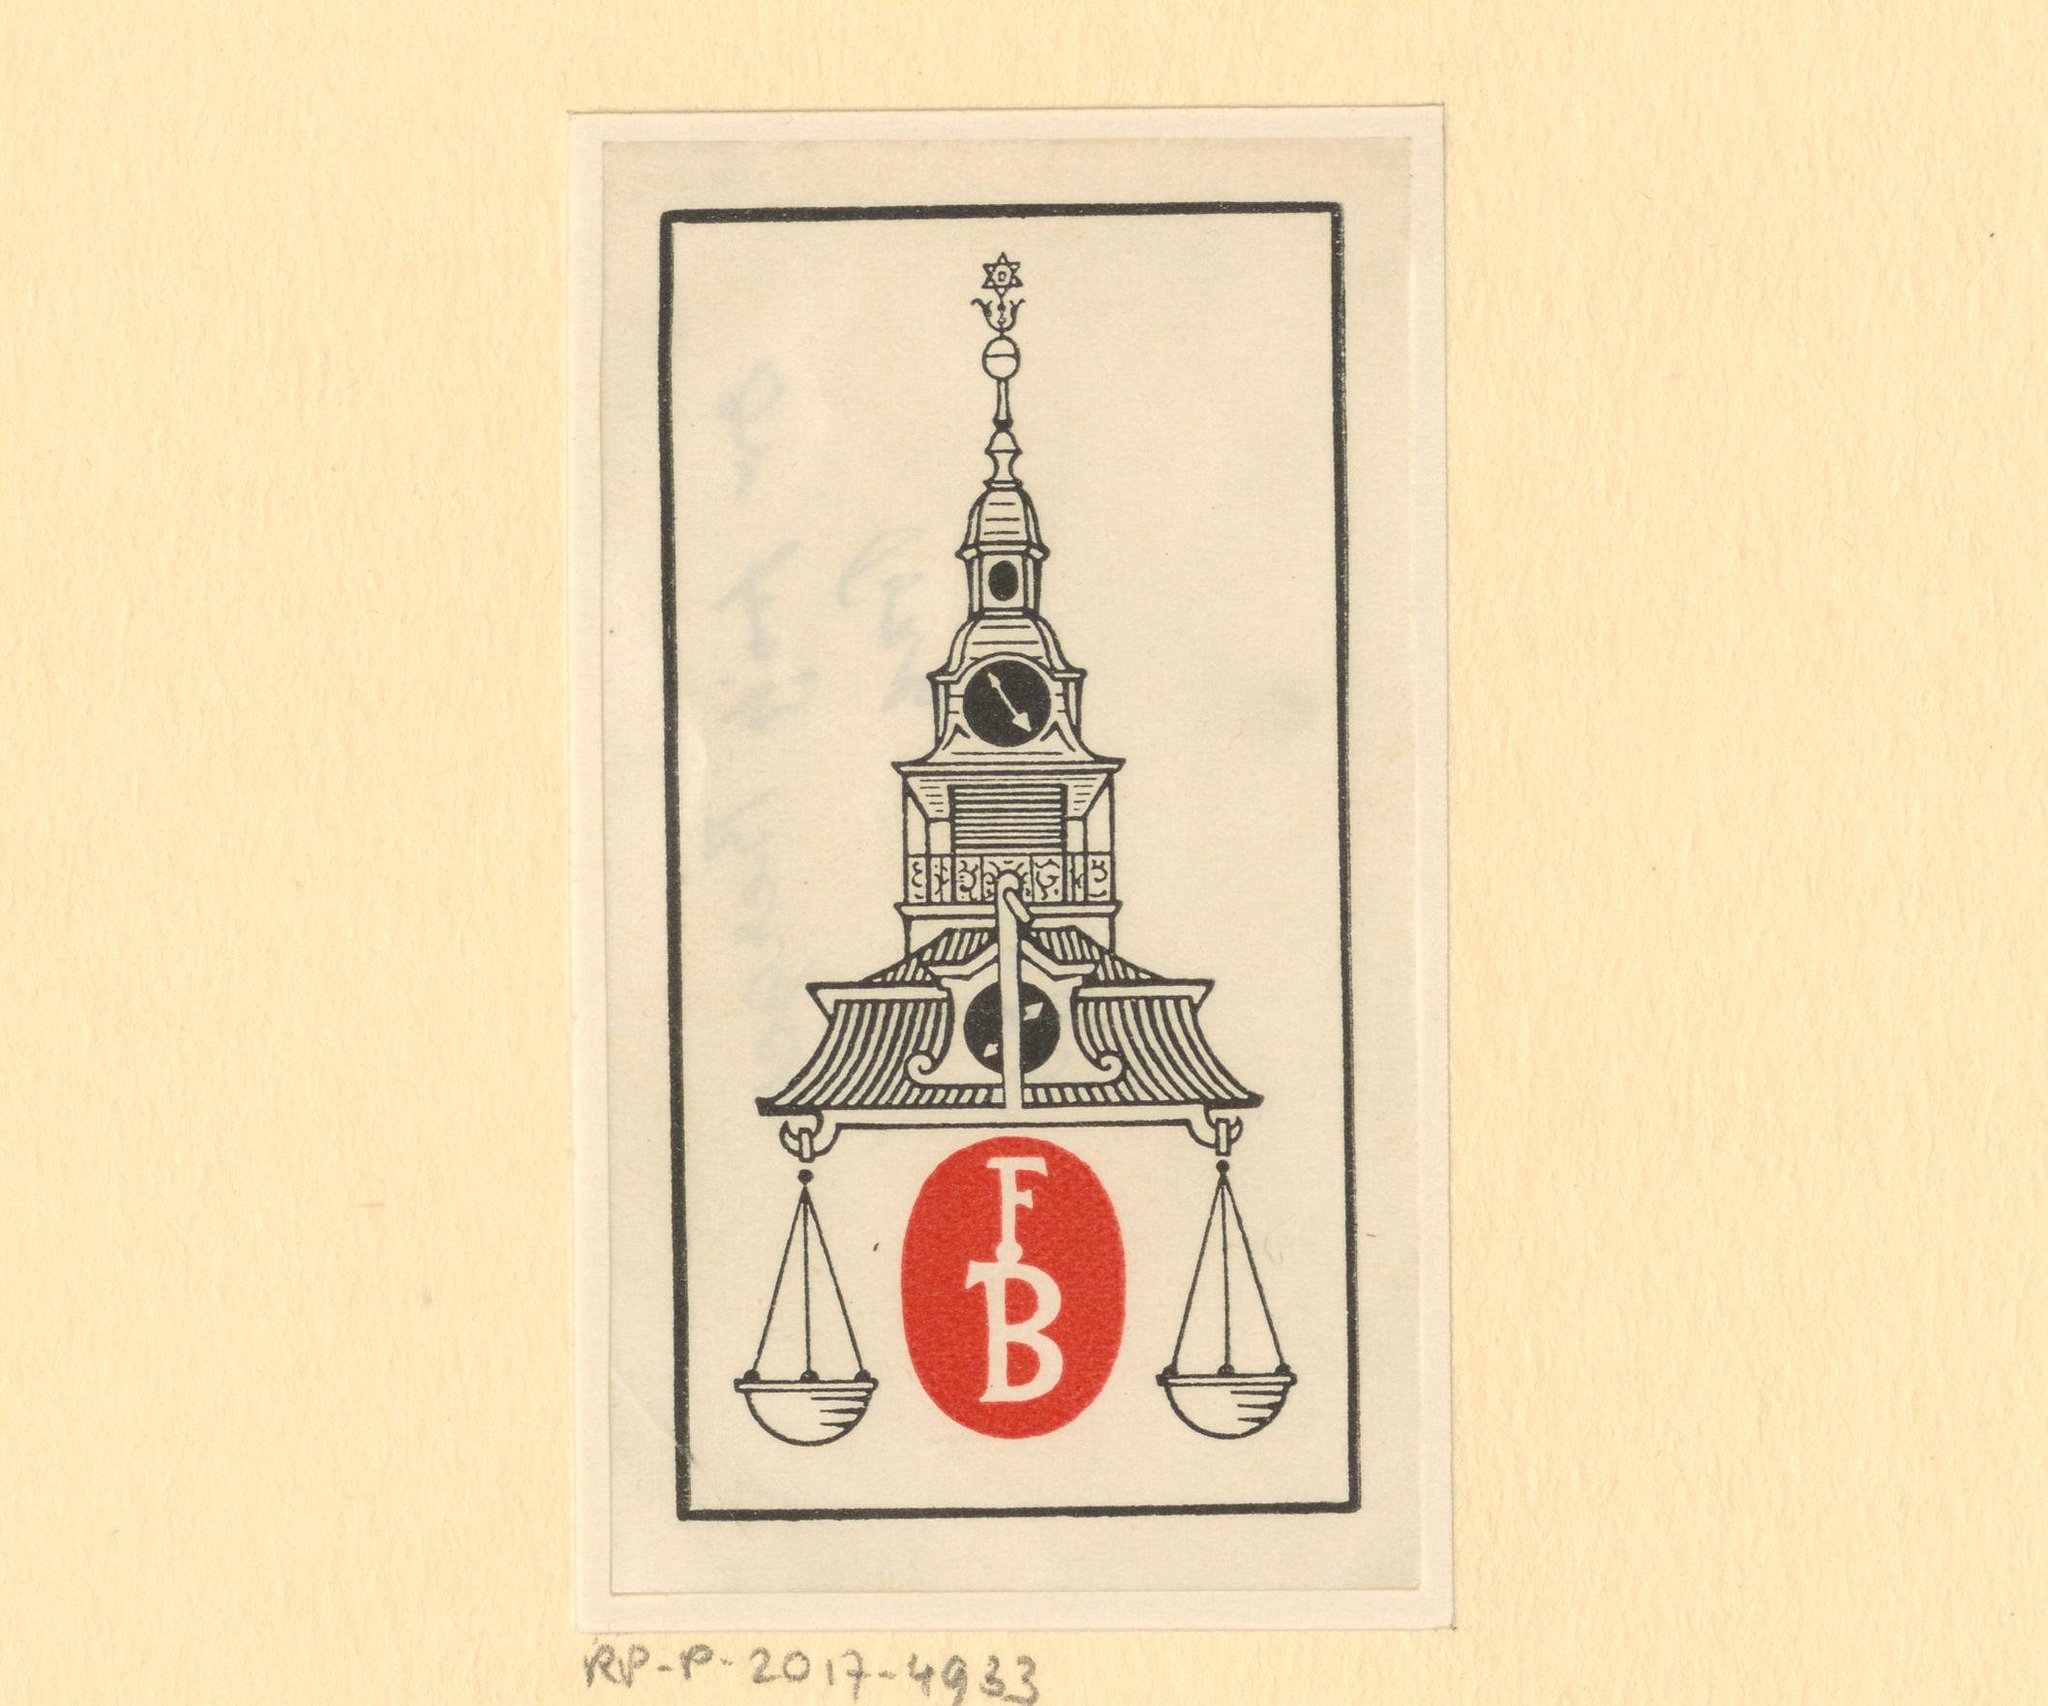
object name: bookplate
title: Ex libris F.B.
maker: Anonymous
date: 1936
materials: paper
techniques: printing block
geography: germany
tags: tower, clock tower ~ monumental adornment, weighing-instruments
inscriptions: inscription: ‘Hugo Steiner-Prag, cliché 1936 / Dr. Fritz Berger, Prag’, inscription: ‘Dr. Fritz Berger / Prag / 1936’